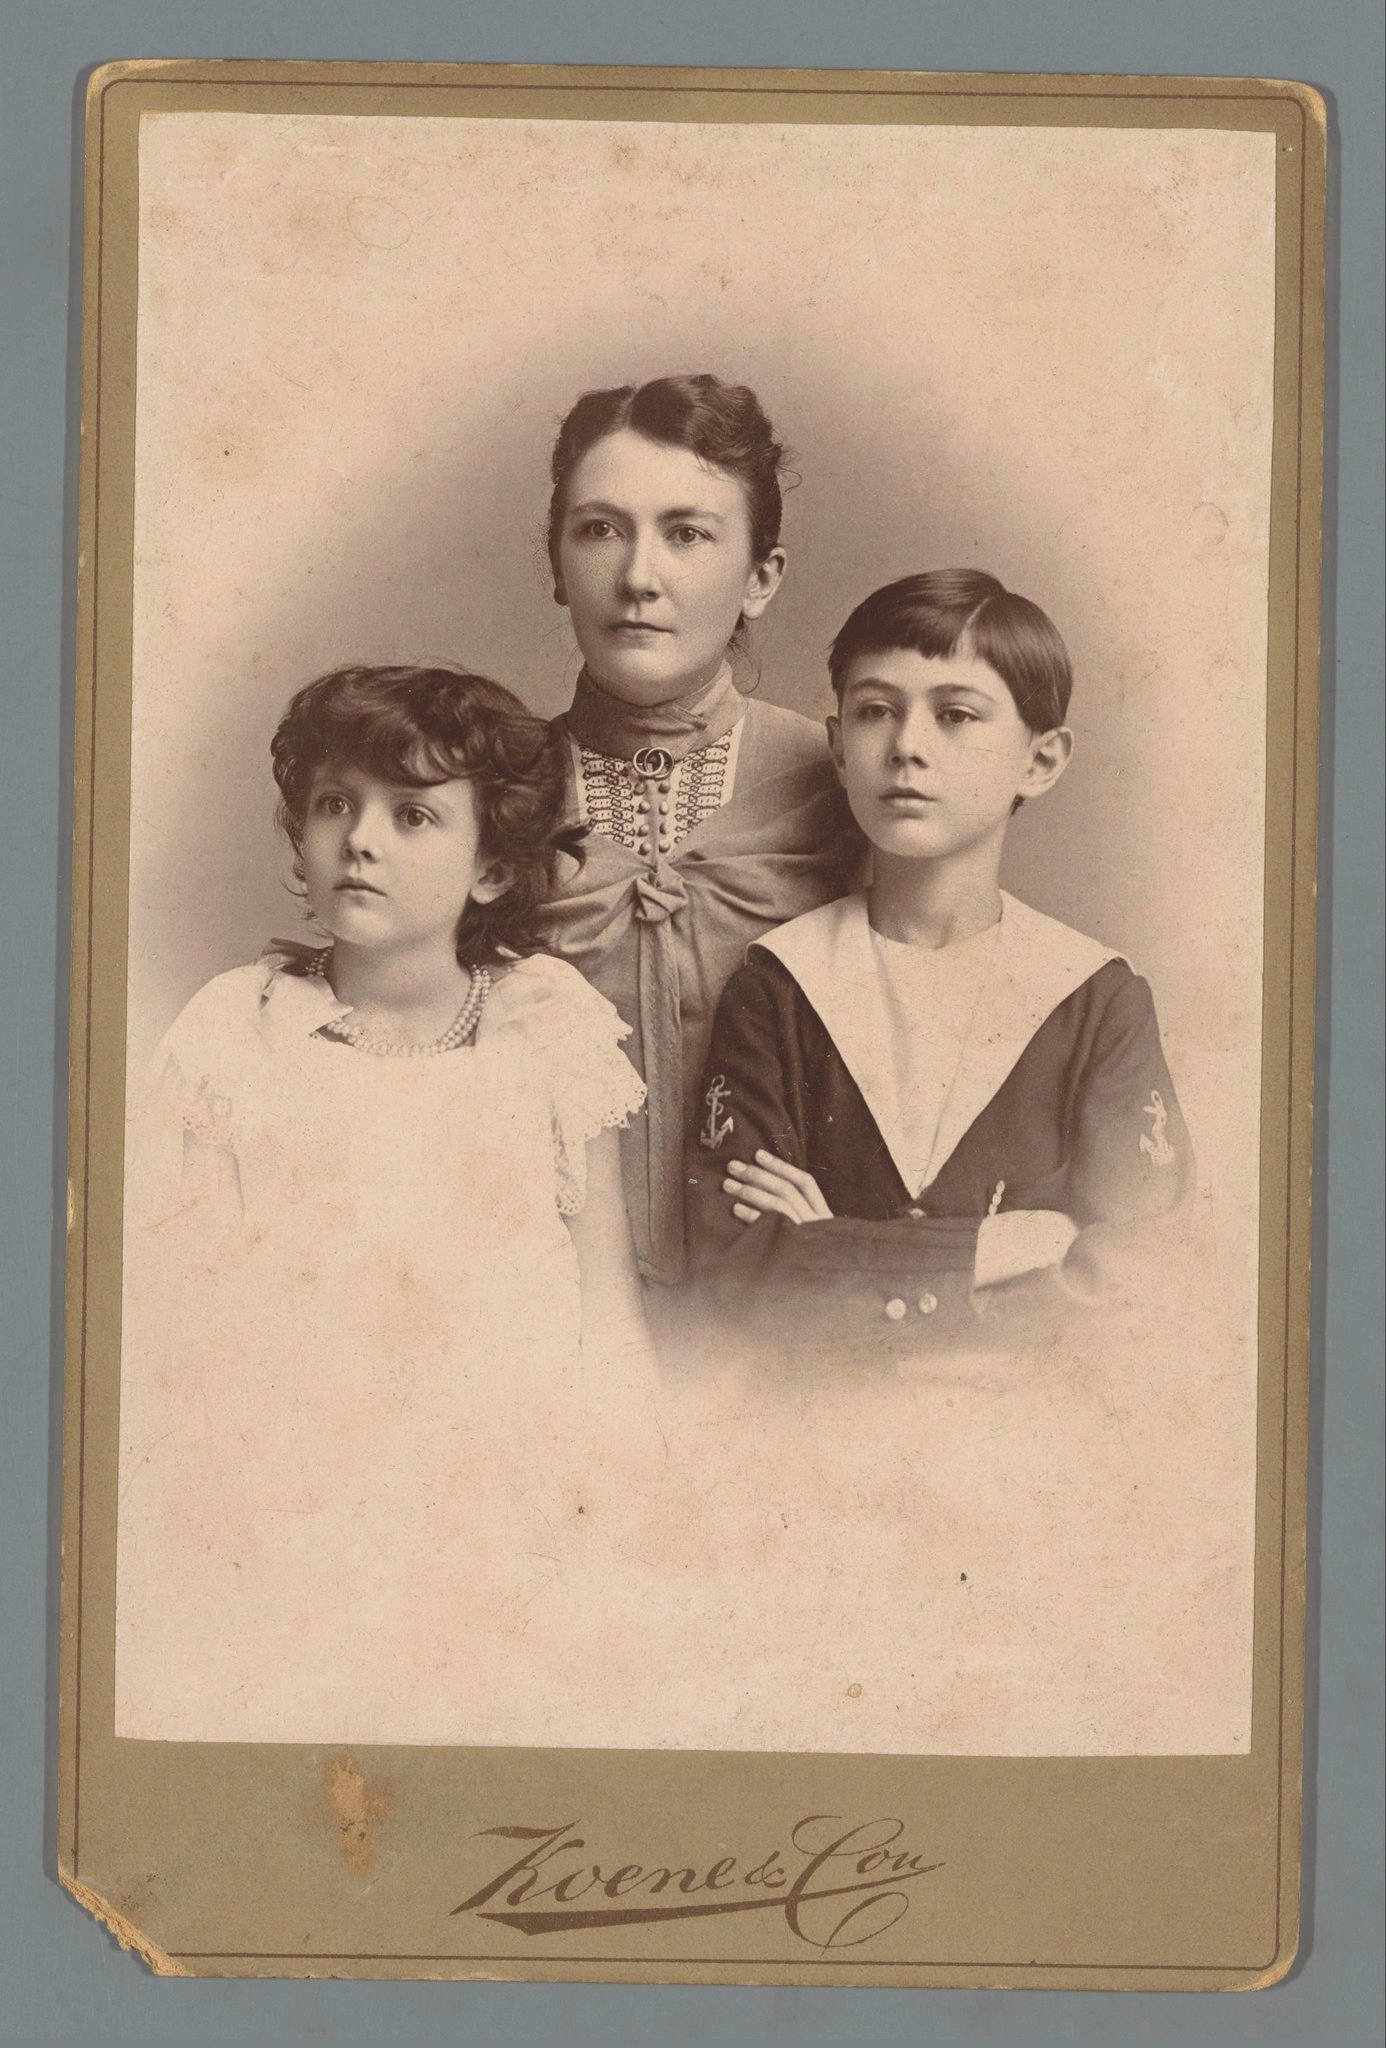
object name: cabinet photograph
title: Portret van vermoedelijk een moeder met haar twee kinderen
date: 1903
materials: cardboard, photographic support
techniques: collodion silver print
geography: batavia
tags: mother with son(s) and daughter(s) (mother-love)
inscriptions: name: ‘Koene & Co Batavia Amsterdam Alkmaar.’